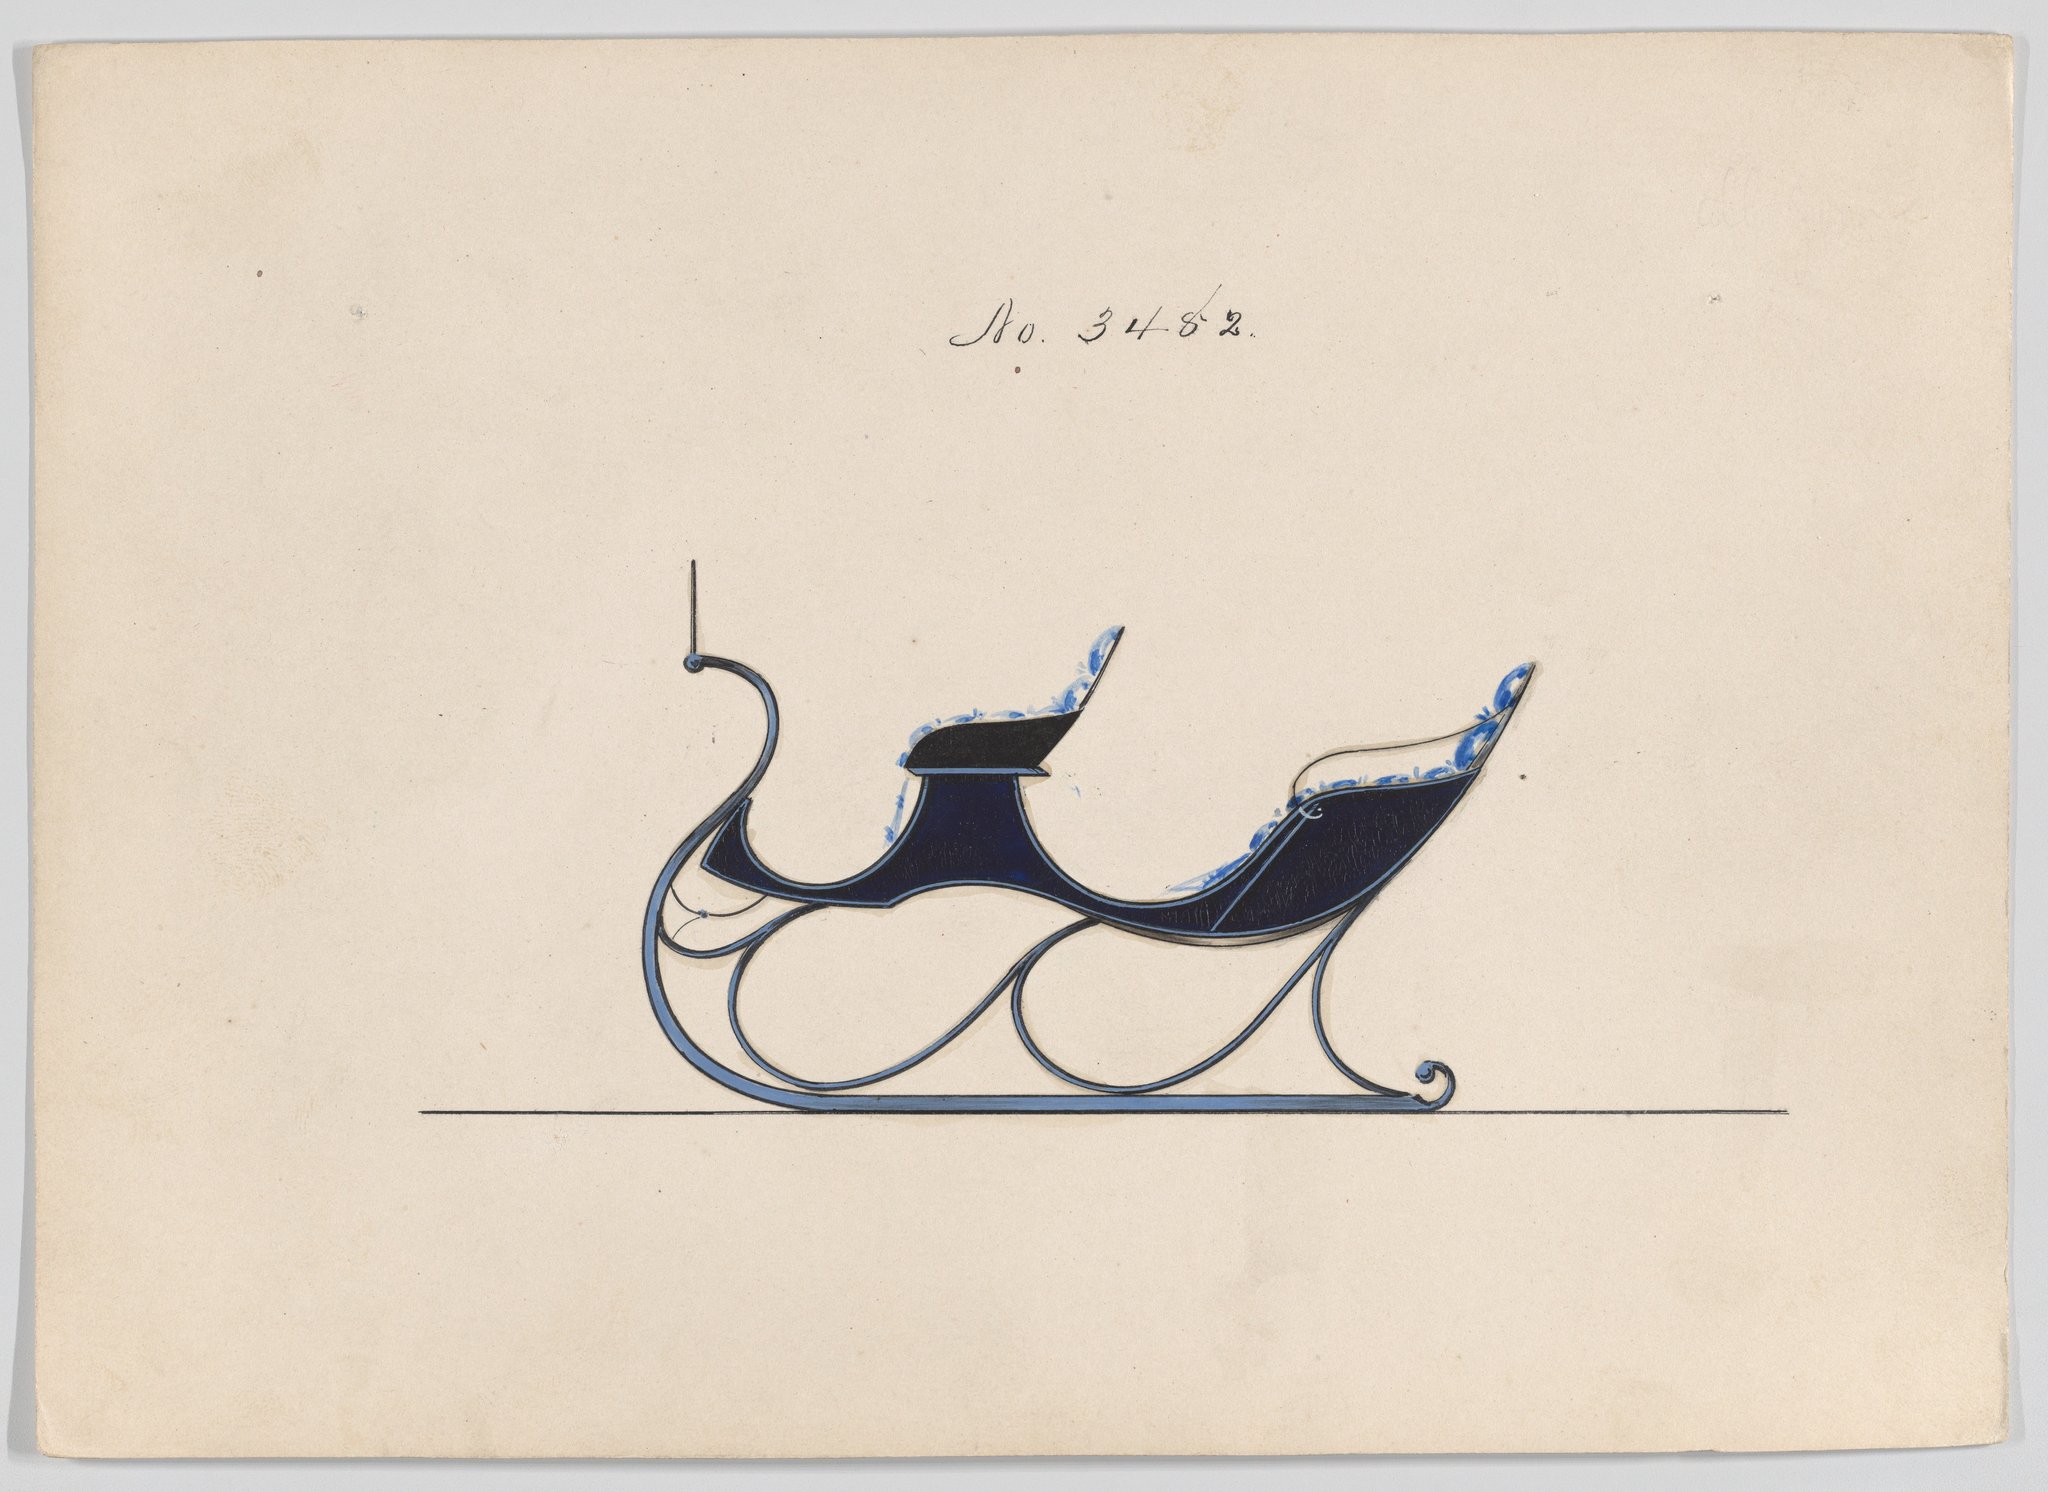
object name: drawing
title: Design for Round Bottom Victoria Sleigh, no. 3482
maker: brewster & co.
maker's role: manufacturer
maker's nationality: american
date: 1879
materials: gouache, gum arabic, ink, watercolor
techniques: pen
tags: sleighs